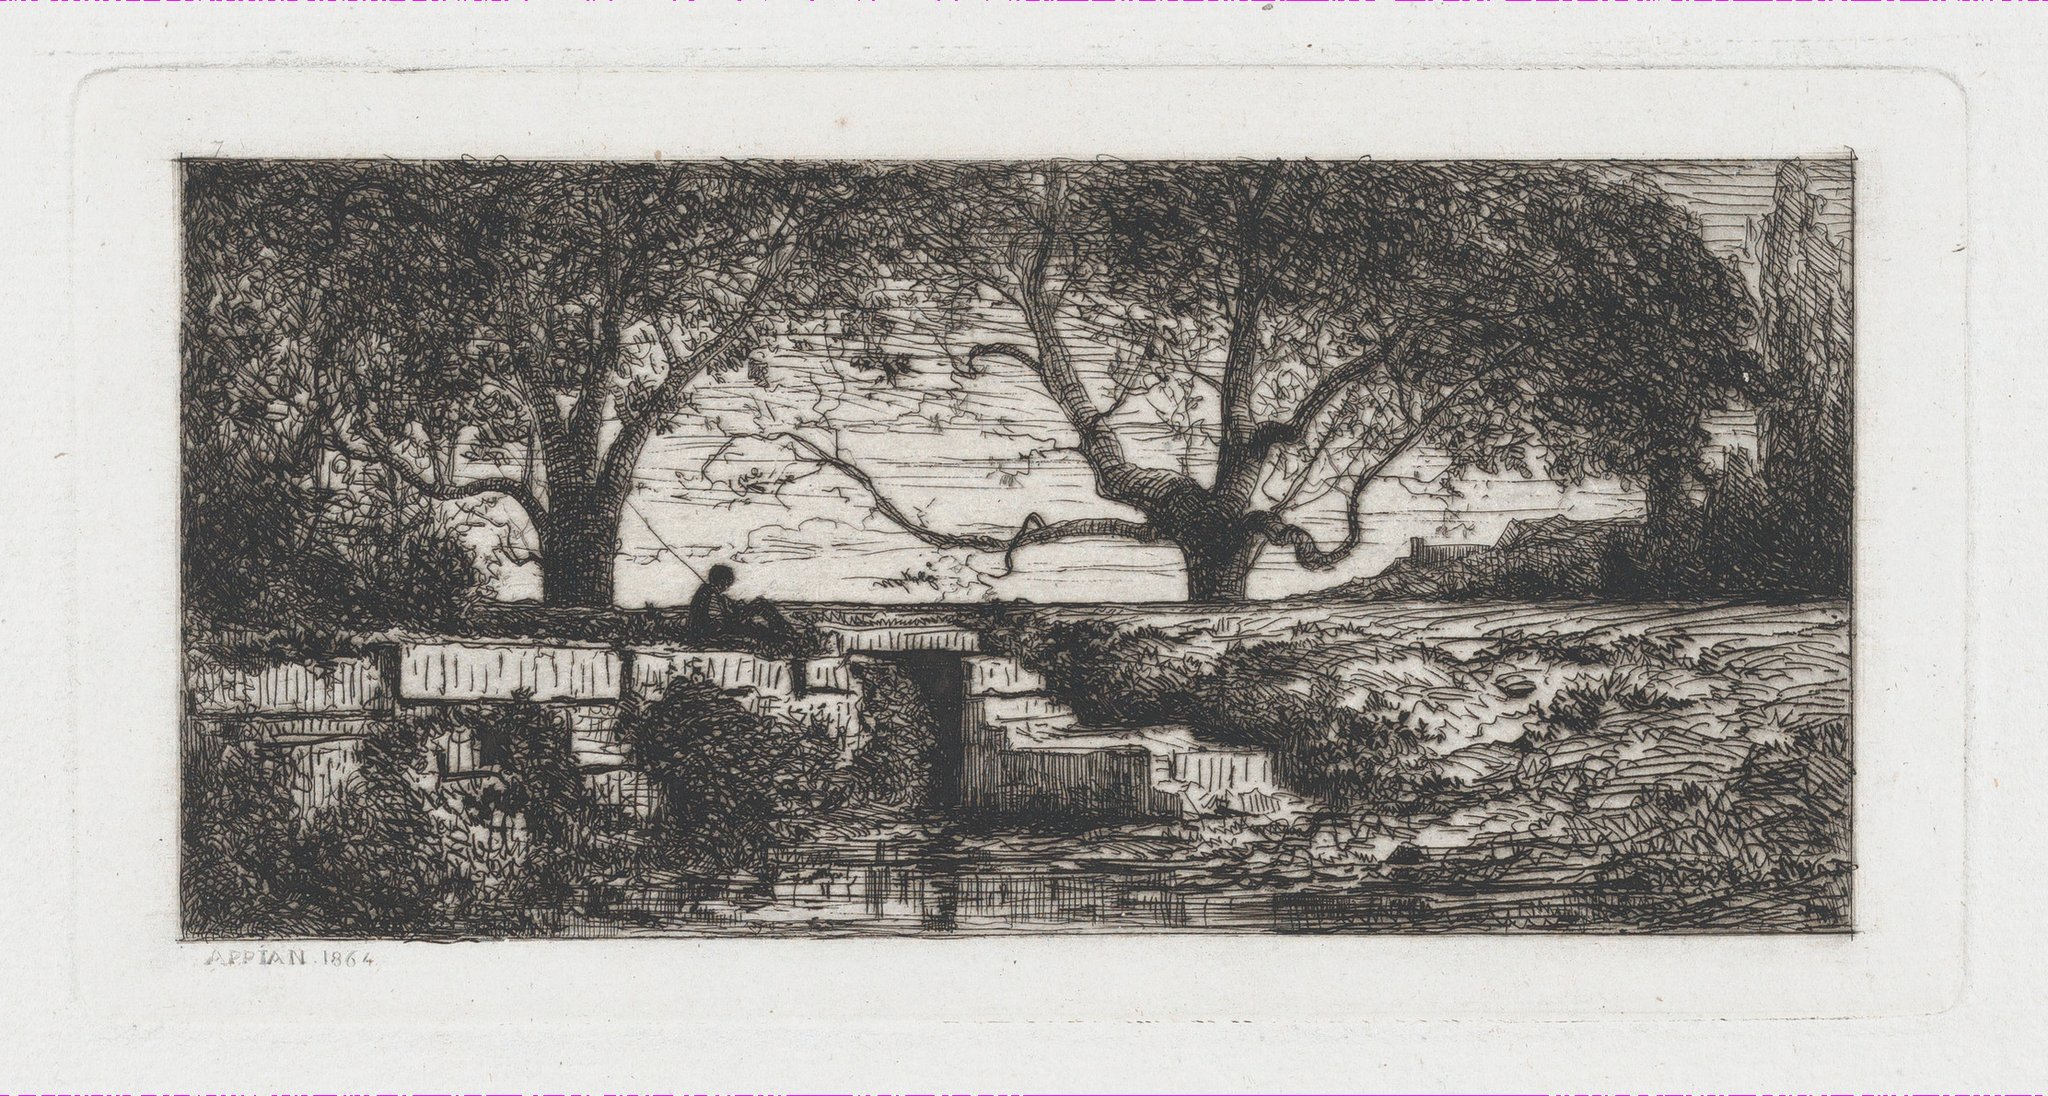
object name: print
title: Near the Rix (Ain)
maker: adolphe appian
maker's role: artist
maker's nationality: french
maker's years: 1818-1898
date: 1864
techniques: etching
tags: landscapes,trees